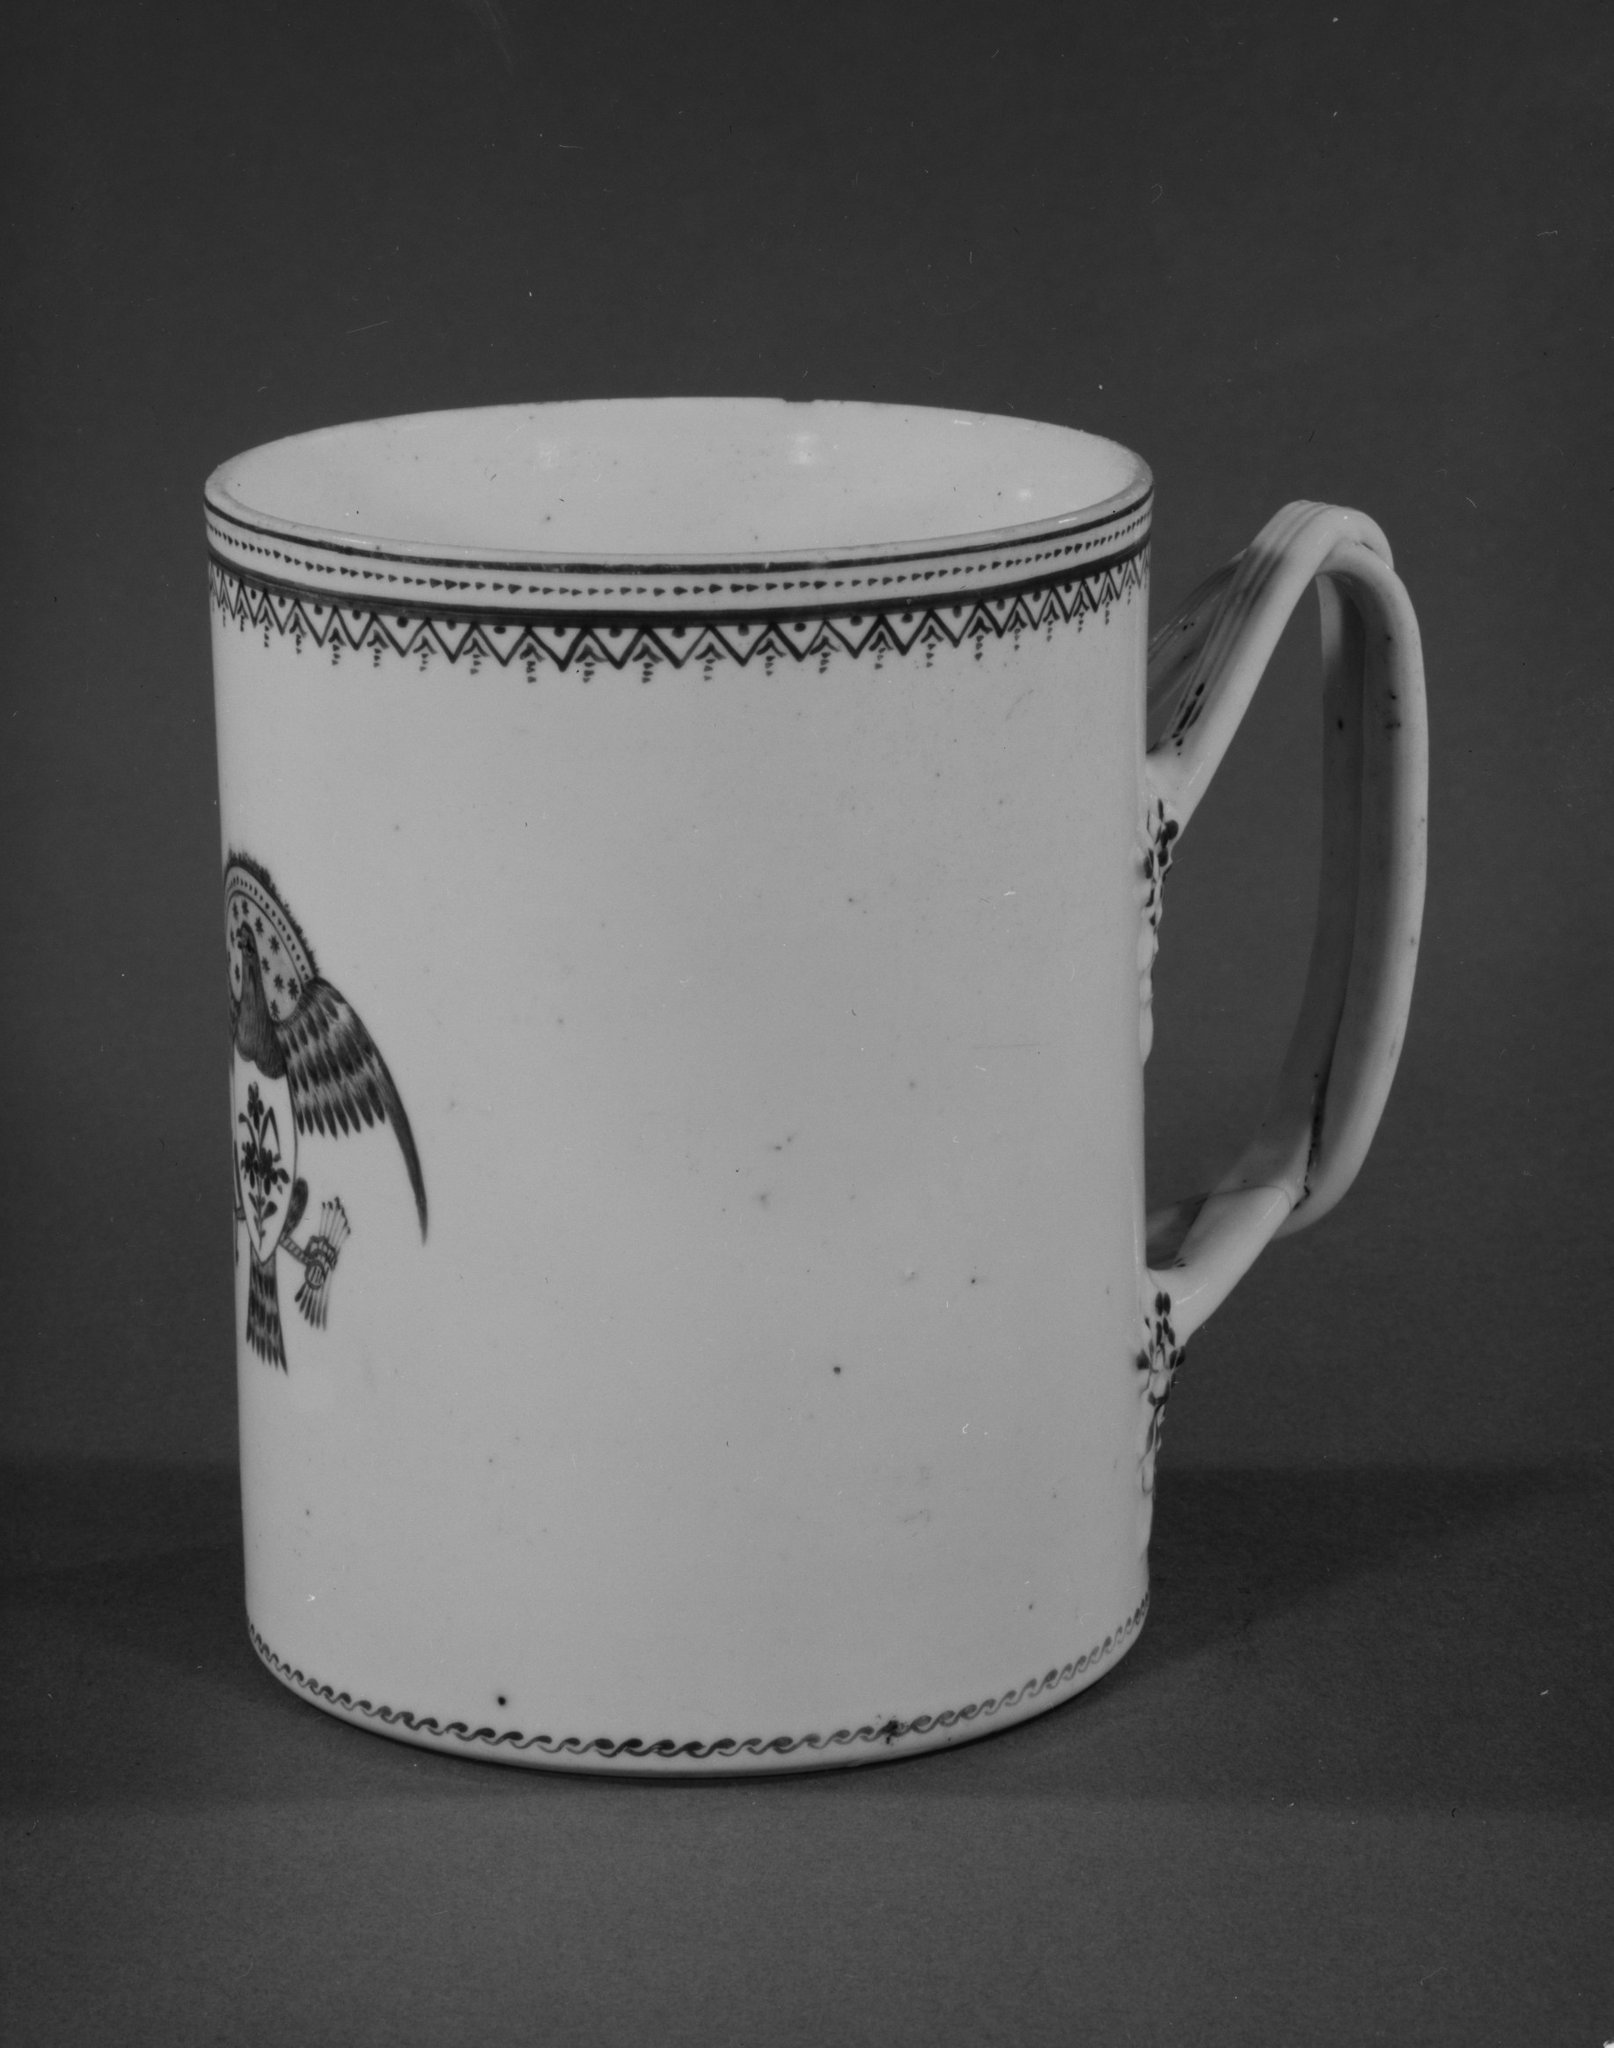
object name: mug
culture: chinese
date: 1800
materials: porcelain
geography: china